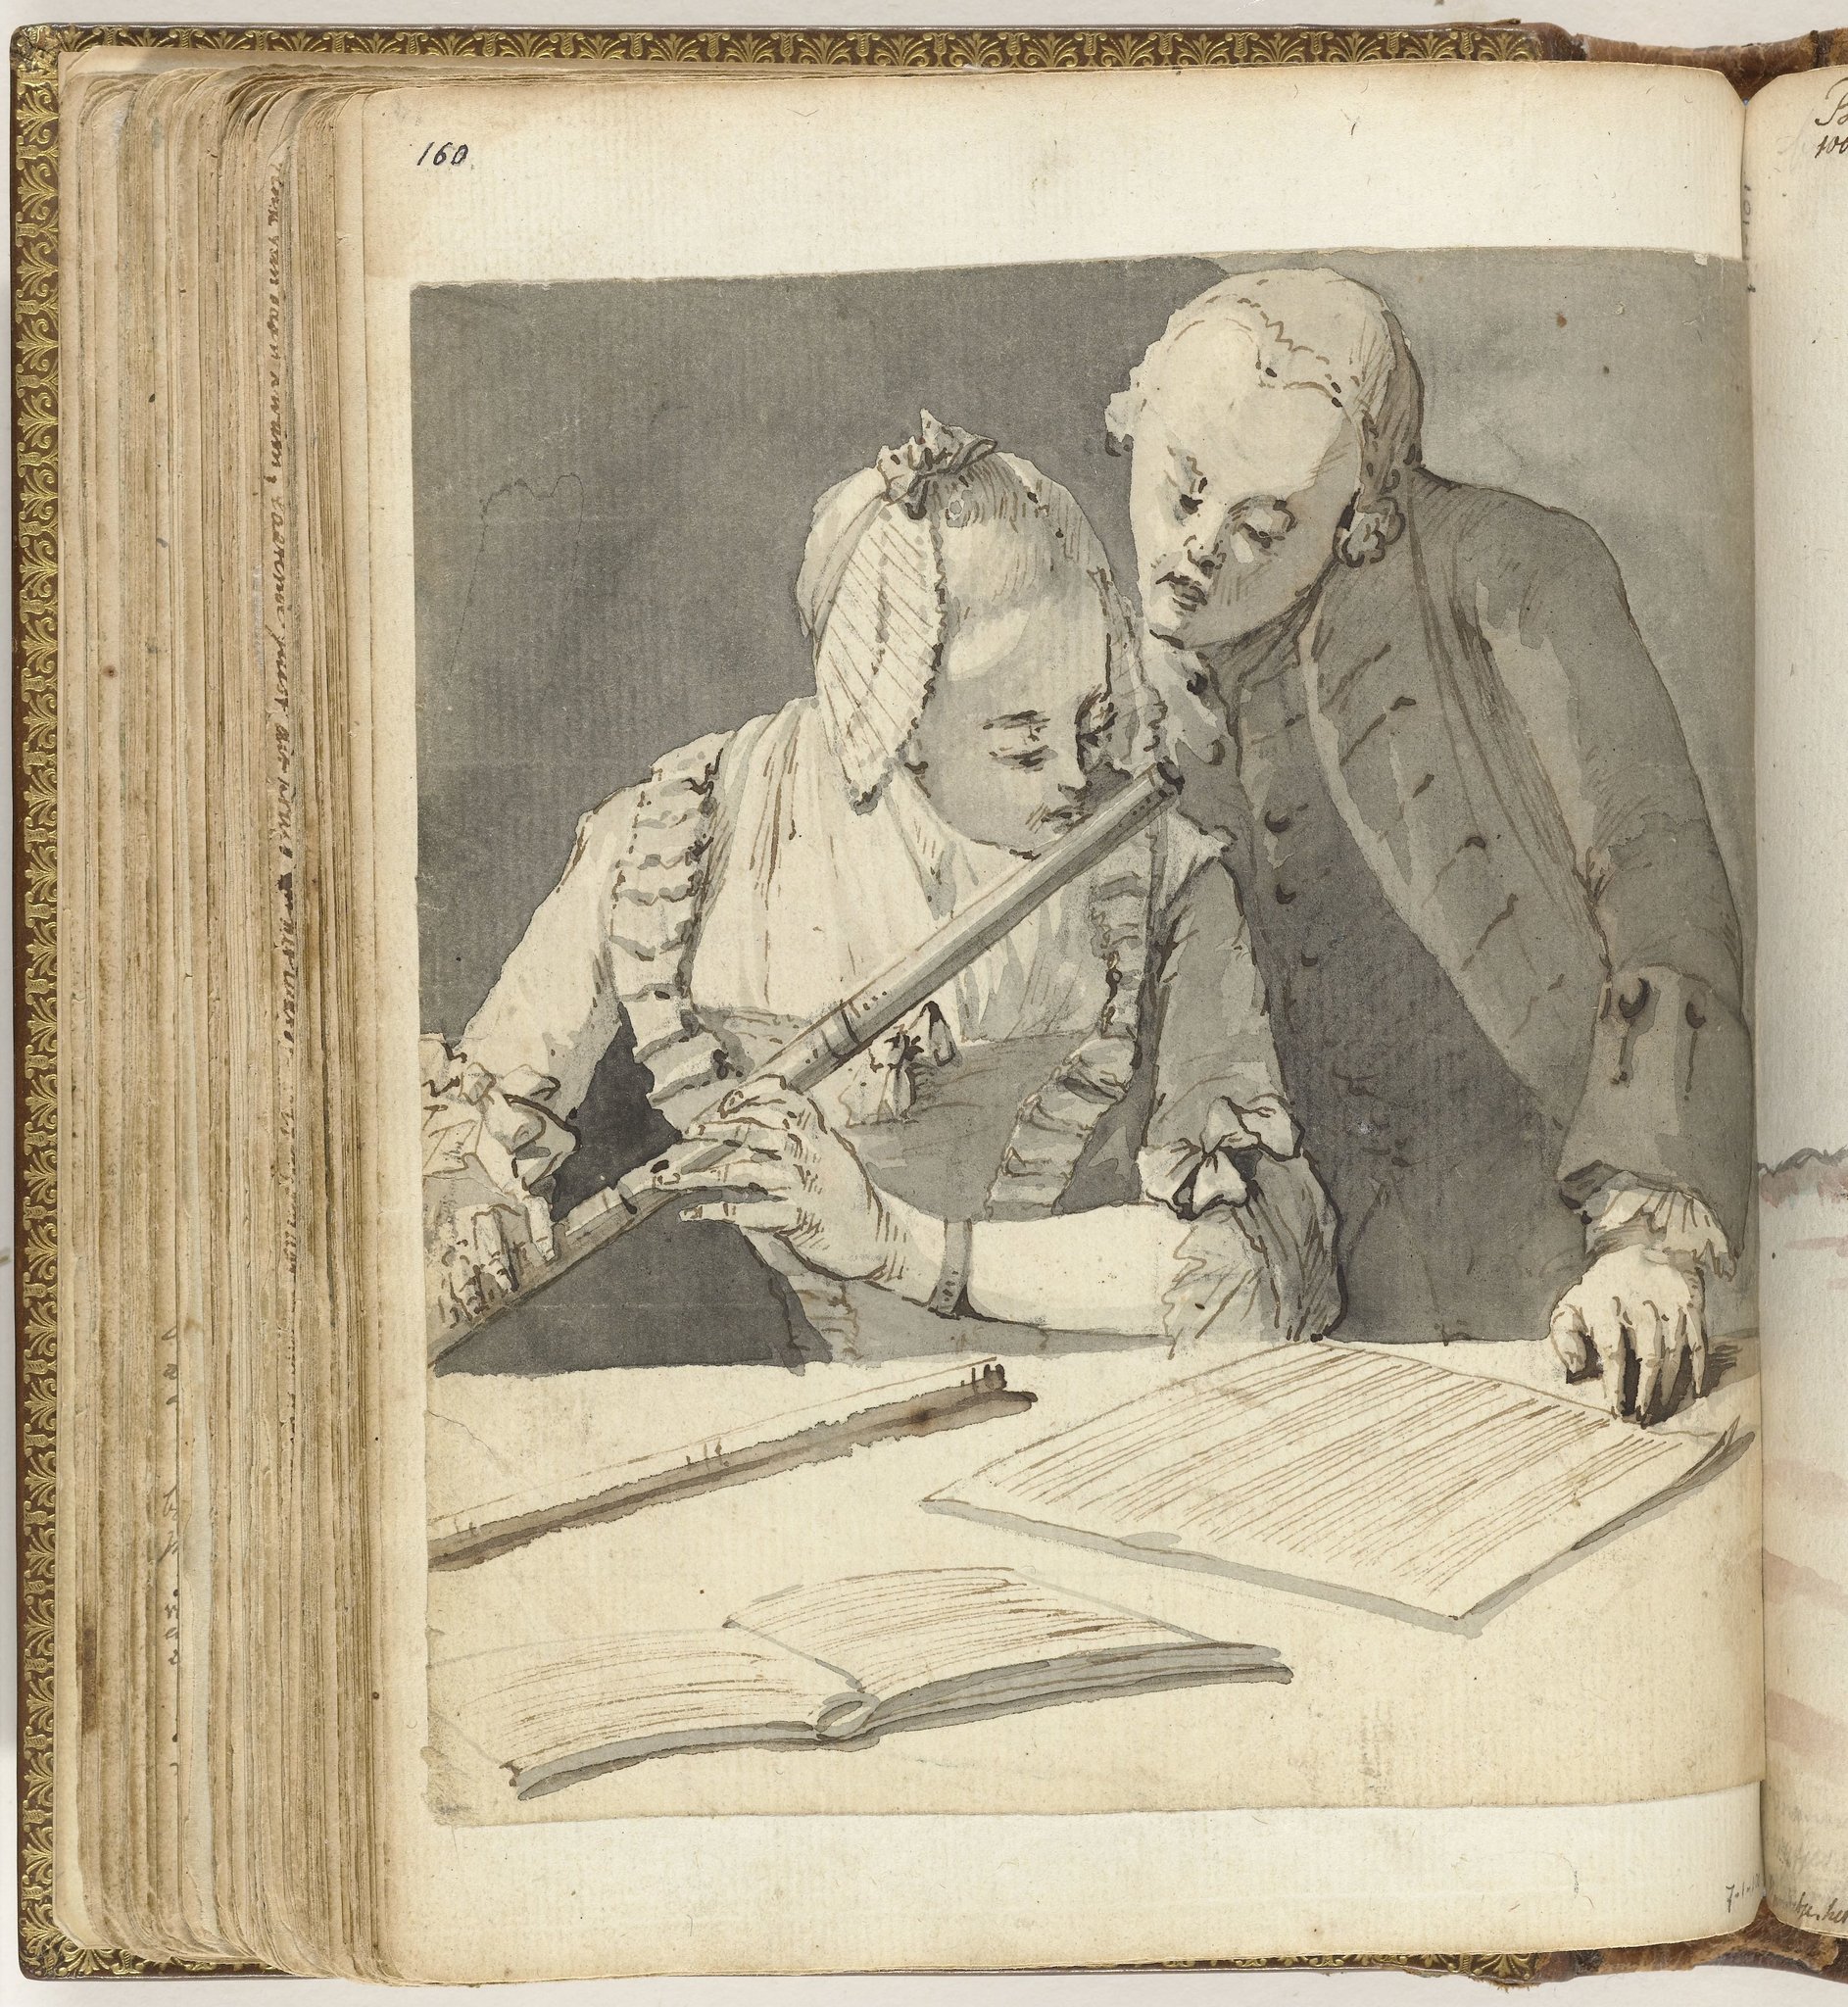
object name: drawing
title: Man en vrouw met dwarsfluit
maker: jan brandes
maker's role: draughtsman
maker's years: 1743-1808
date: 1770-1808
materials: ink, paper, pencil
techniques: brush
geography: jakarta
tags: notation of music, transverse flute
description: Zwartwittekening van een man en vrouw achter een tafel met bladmuziek. De vrouw fluit, de man leest de muziek mee en slaat om. Onderdeel uit het schetsboek van Jan Brandes, dl. 1 (1808), p. 160.